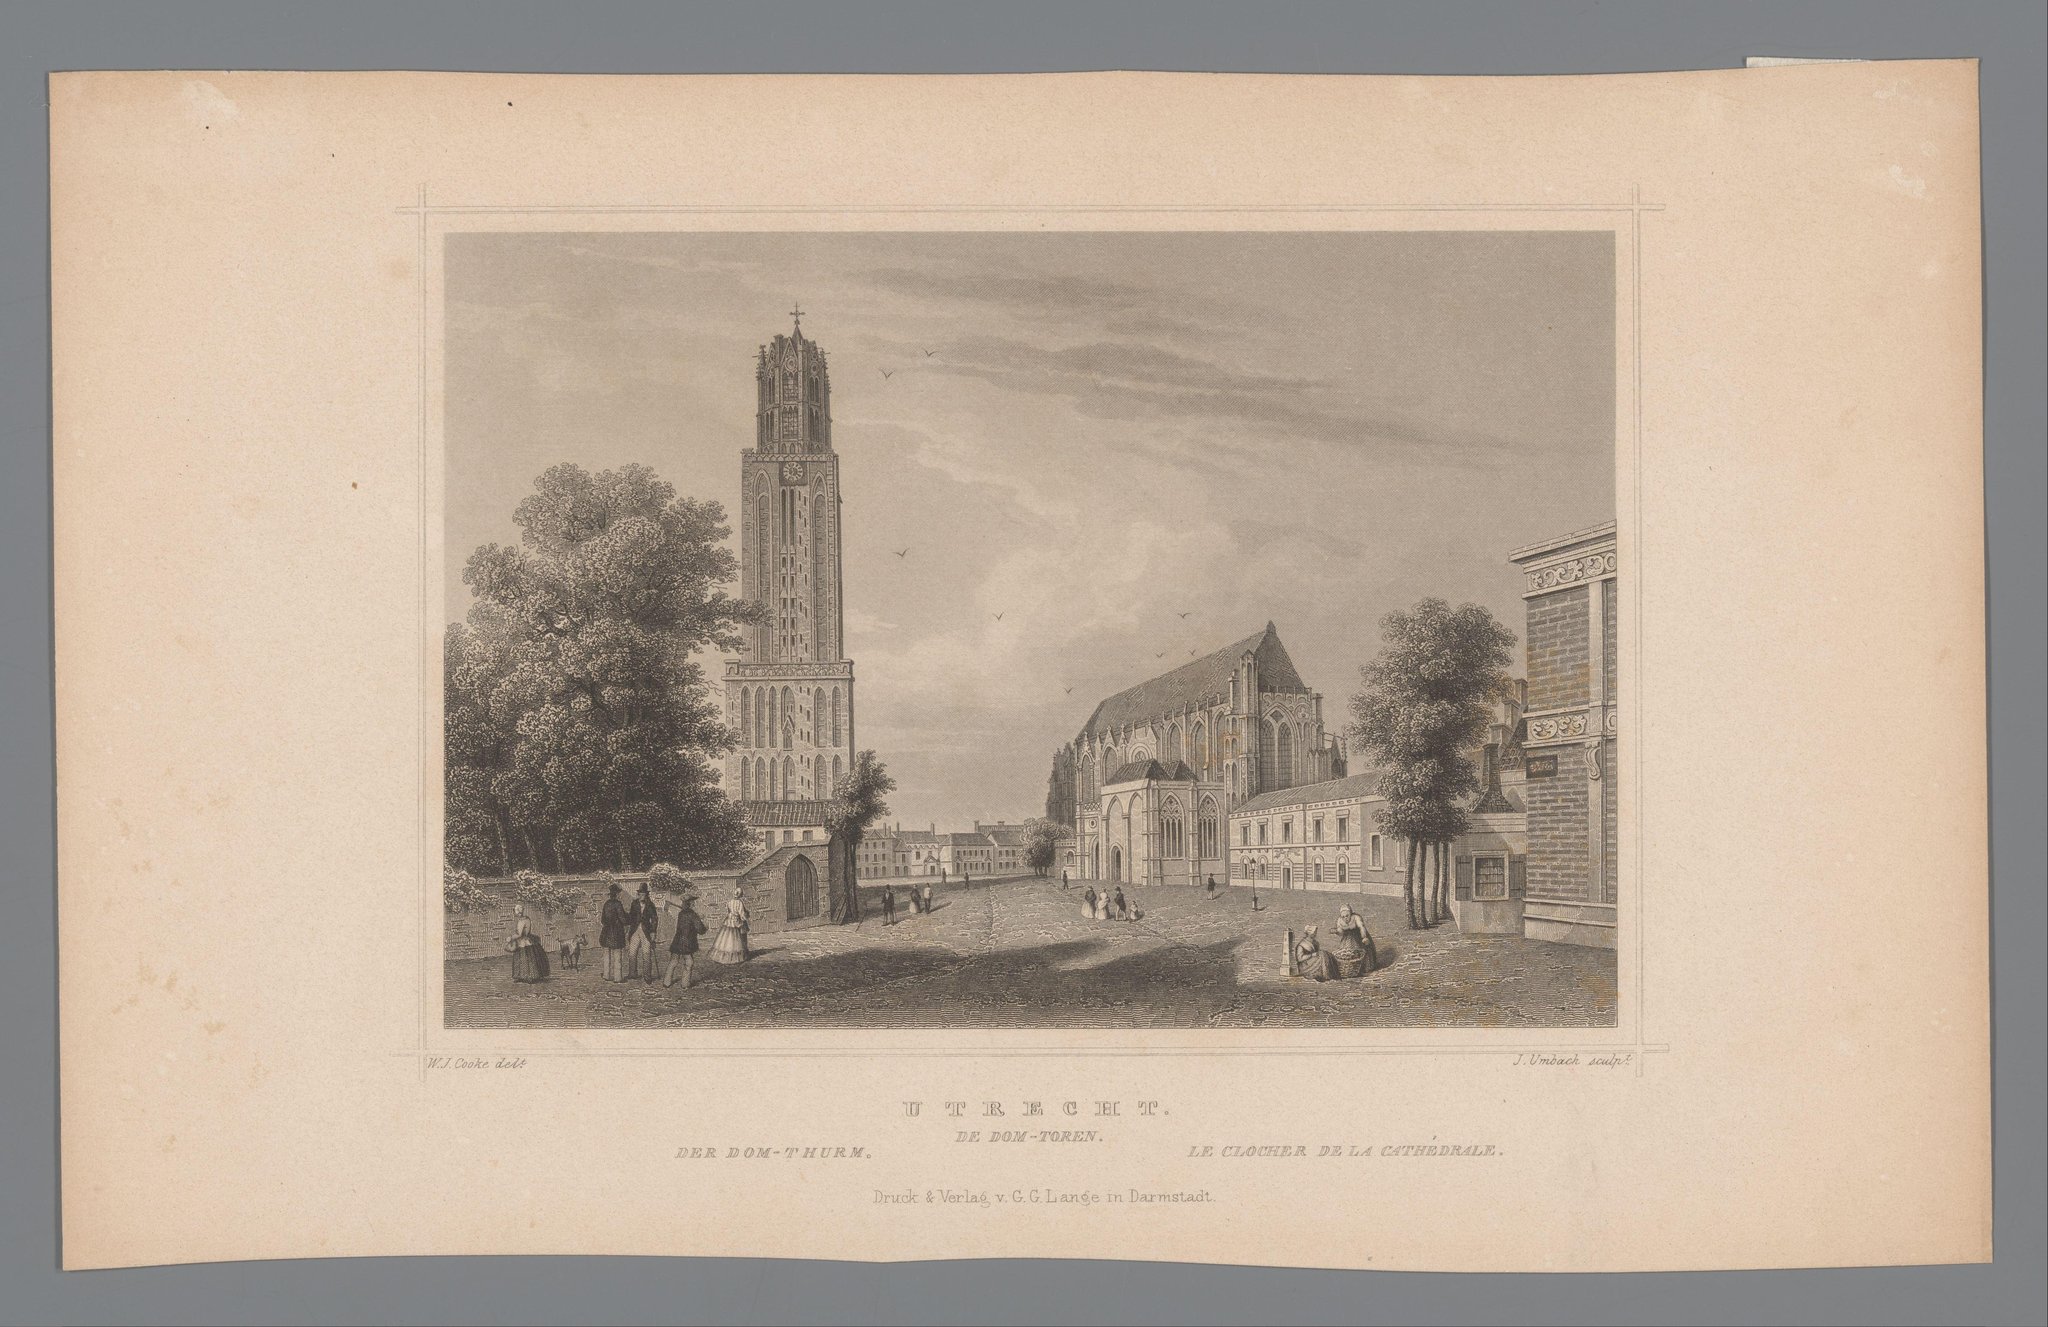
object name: print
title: Utrecht. De Dom-toren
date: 1863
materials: paper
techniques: engraving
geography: darmstadt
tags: city-view, and landscape with man-made constructions, church (exterior), utrecht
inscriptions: collector's mark: Lugt 2233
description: Prent uit: Terwen, J.L. Het koningrijk der Nederlanden voorgesteld in eene reeks van 136 naar de natuur geteekende schilderachtige gezigten. Darmstadt: G.G. Lange, 1863.